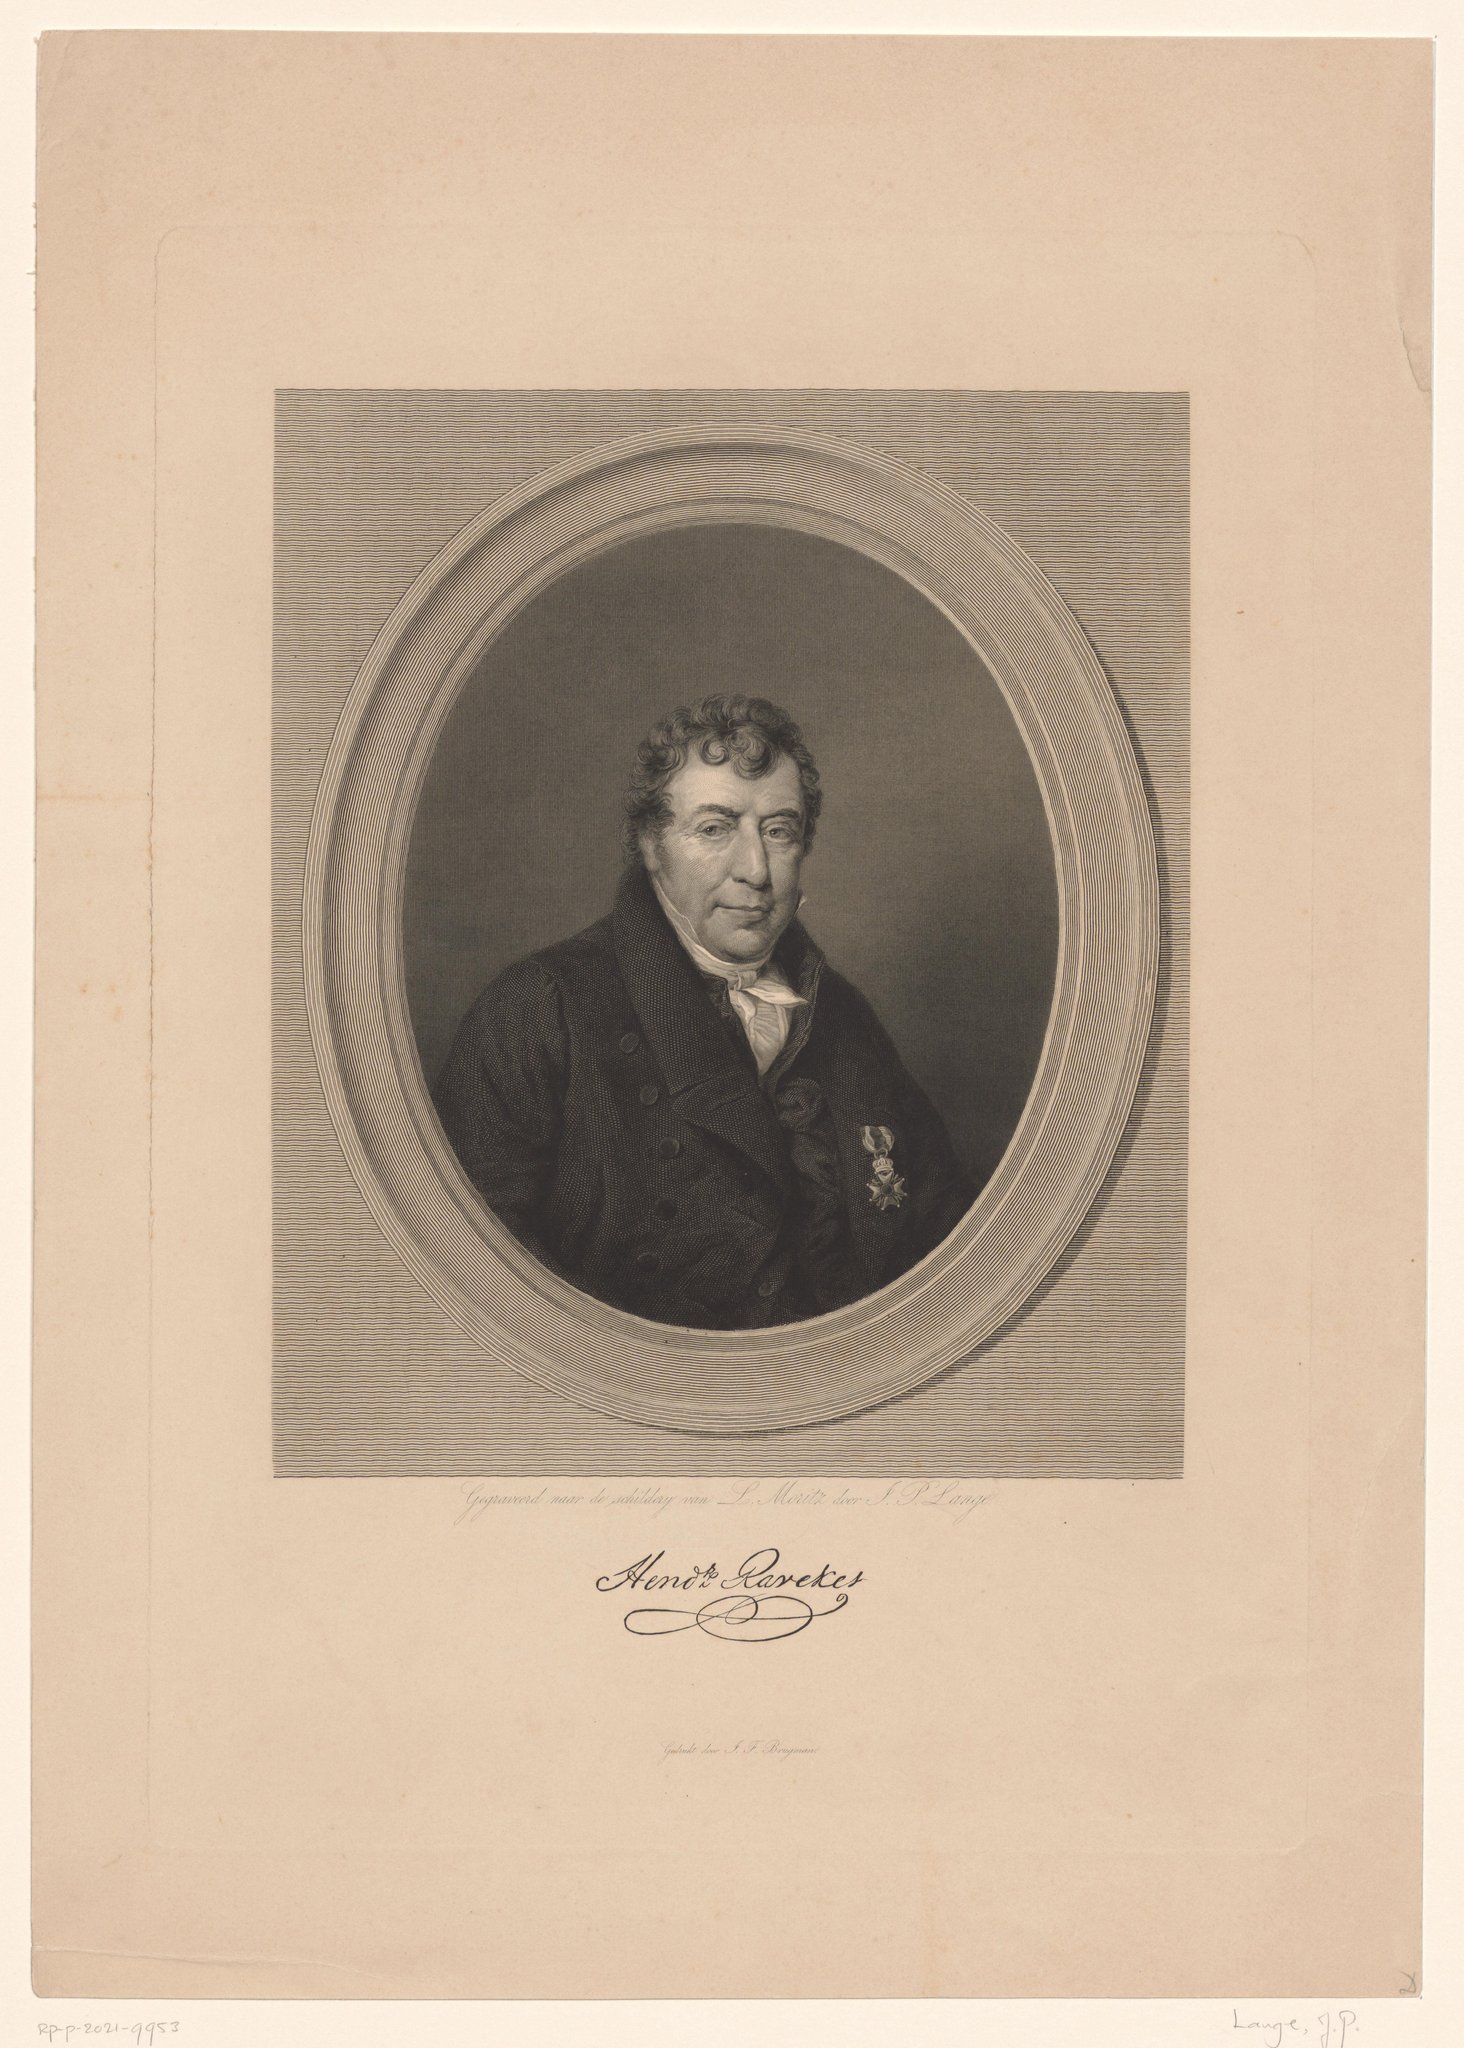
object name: print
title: Portret van Hendrik Ravekes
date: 1831-1879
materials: paper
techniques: engraving, etching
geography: amsterdam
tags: amsterdam, historical persons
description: Onder het portret een facsimile van de handtekening van de geportretteerde.